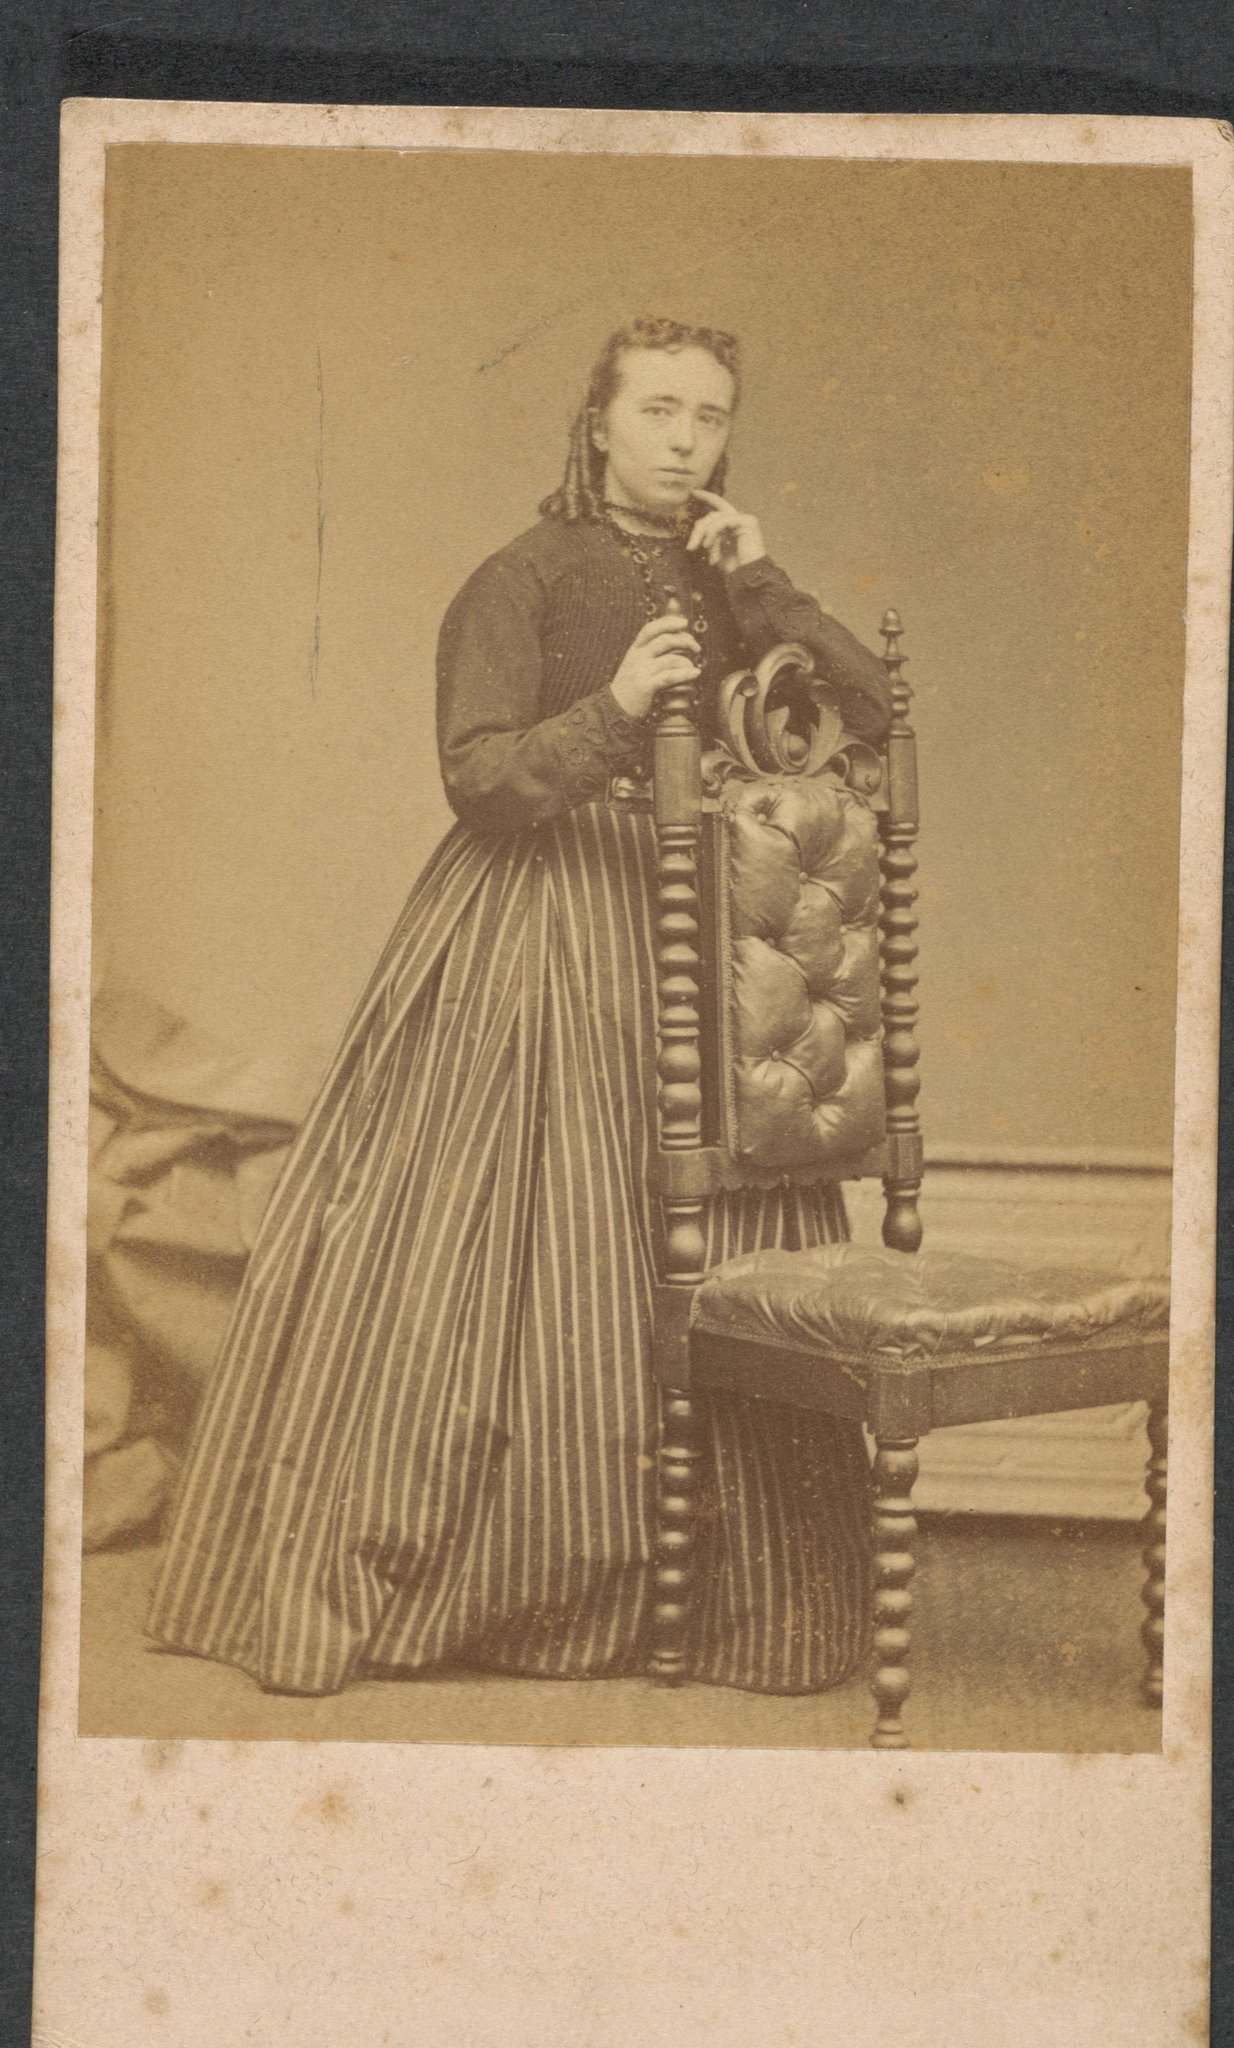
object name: carte de visite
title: Portret van een onbekende vrouw uit de familie Marmelstein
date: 1850-1900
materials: cardboard, photographic support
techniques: albumen print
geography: amsterdam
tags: adult woman, historical persons